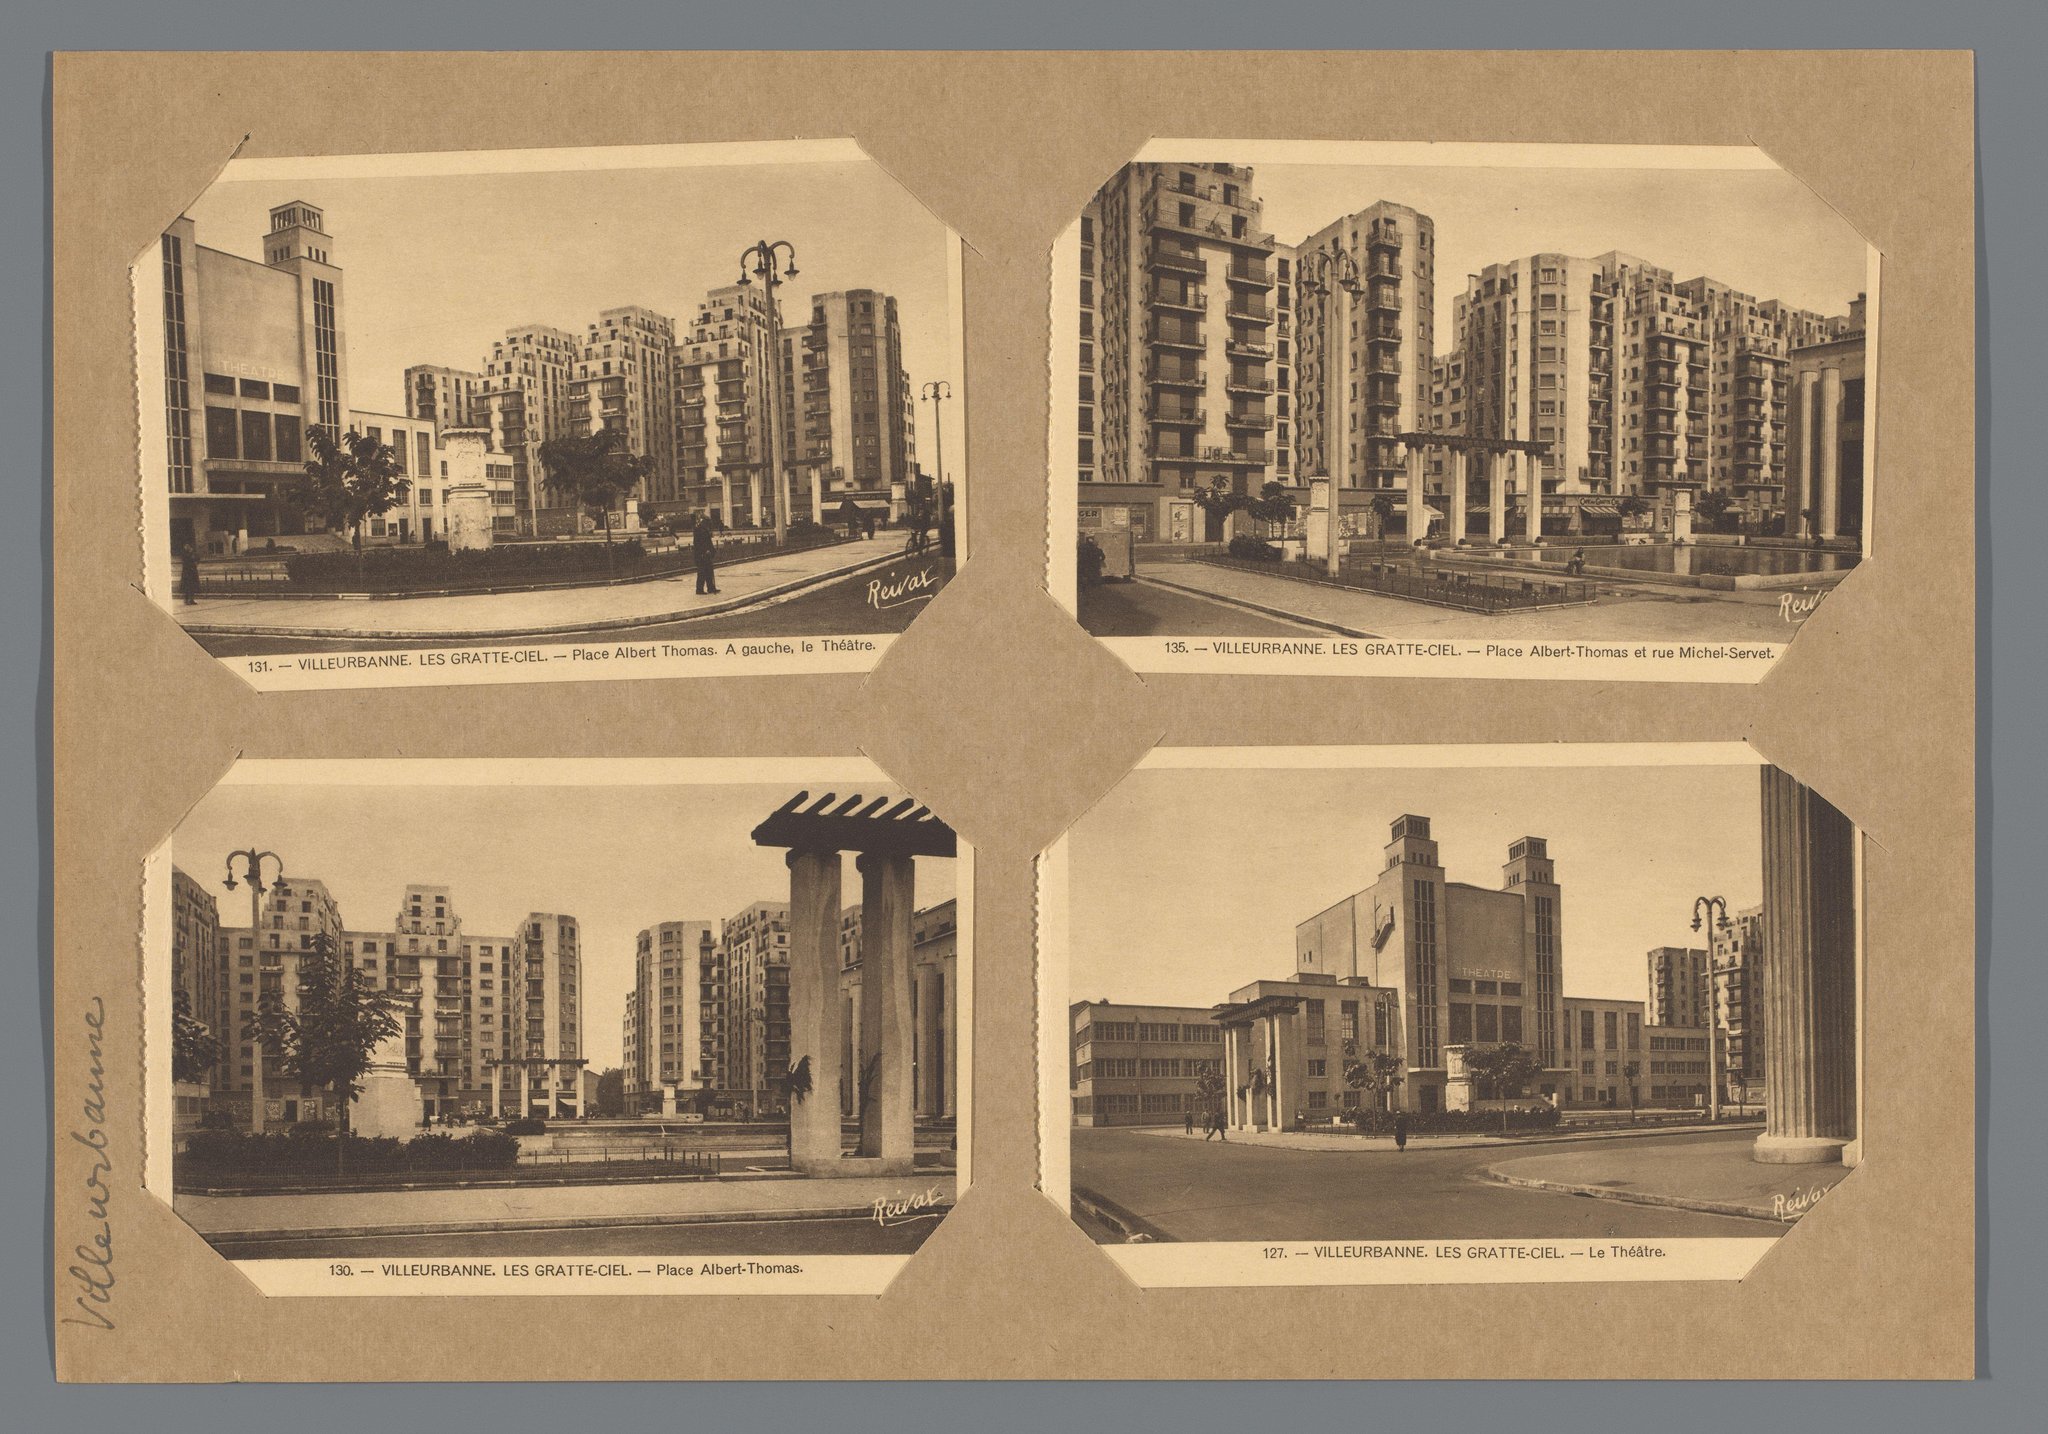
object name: photograph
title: Villeurbanne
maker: Anonymous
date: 1900-1950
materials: paper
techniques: rotogravure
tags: villeurbanne